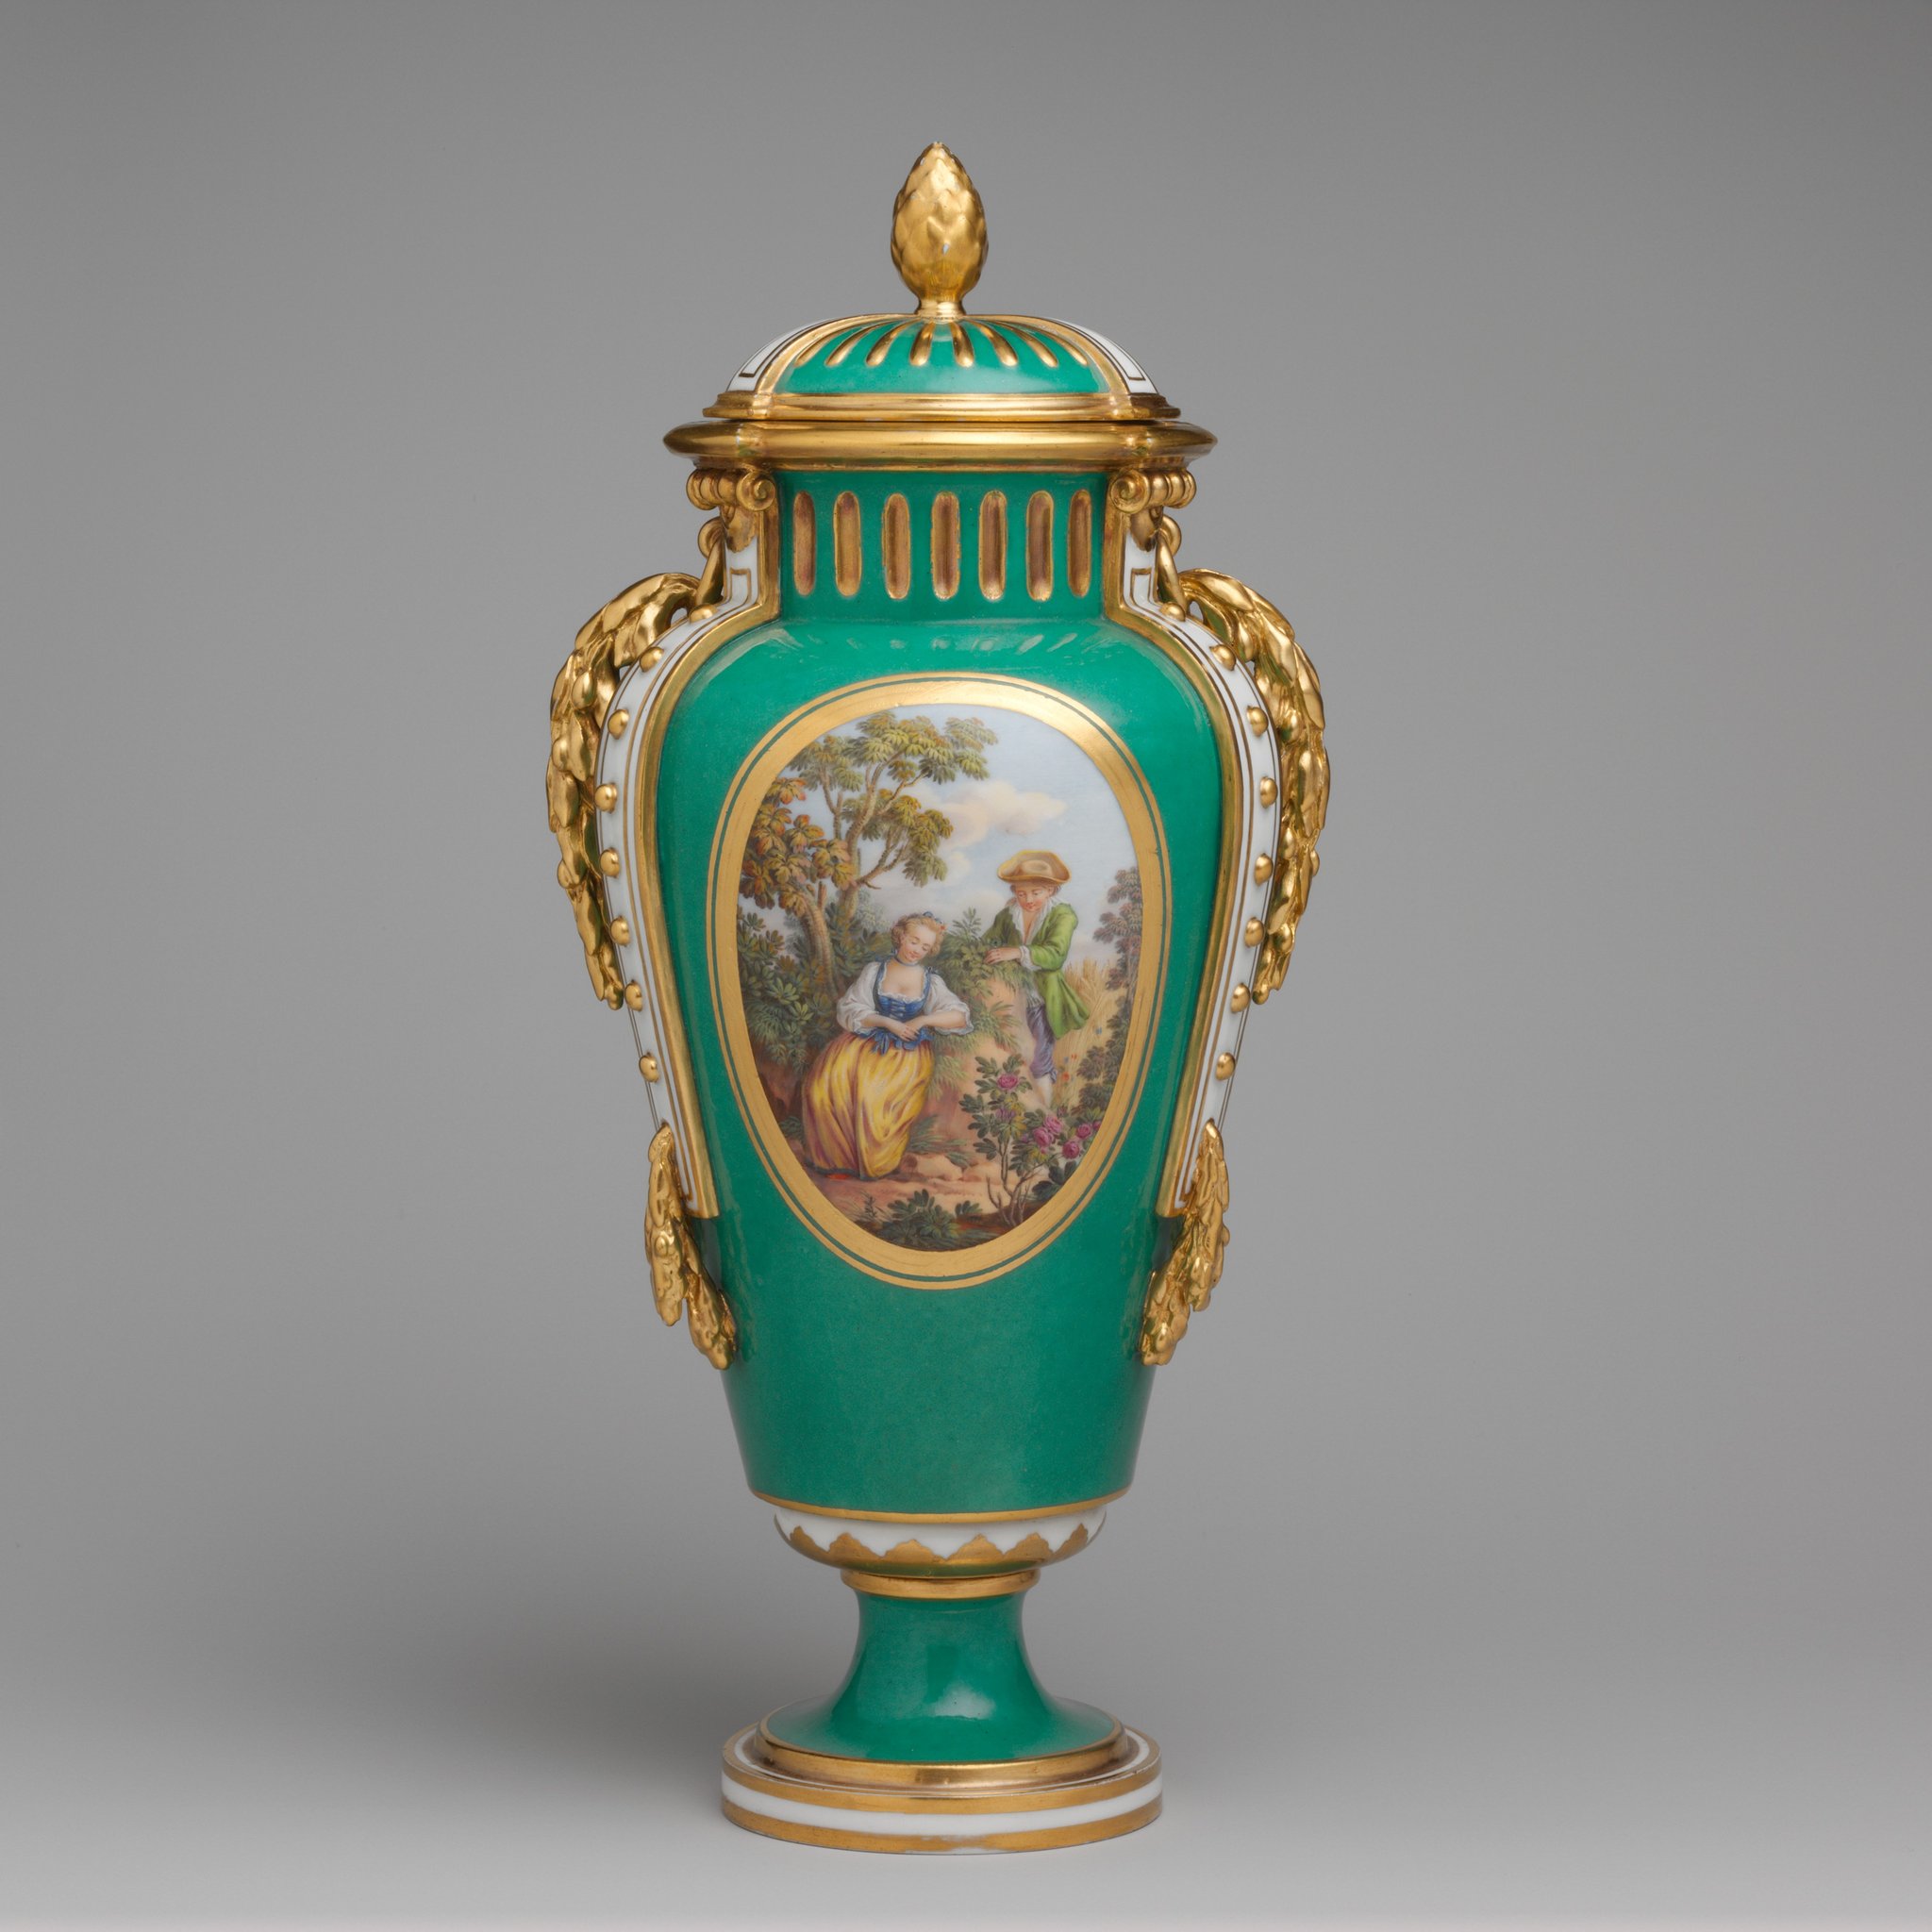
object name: vase with cover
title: Vase with cover (vase à bandes) (one of a pair)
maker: sèvres manufactory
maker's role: manufactory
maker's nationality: french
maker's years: 1740-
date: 1770-1775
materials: soft paste porcelain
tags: men,women